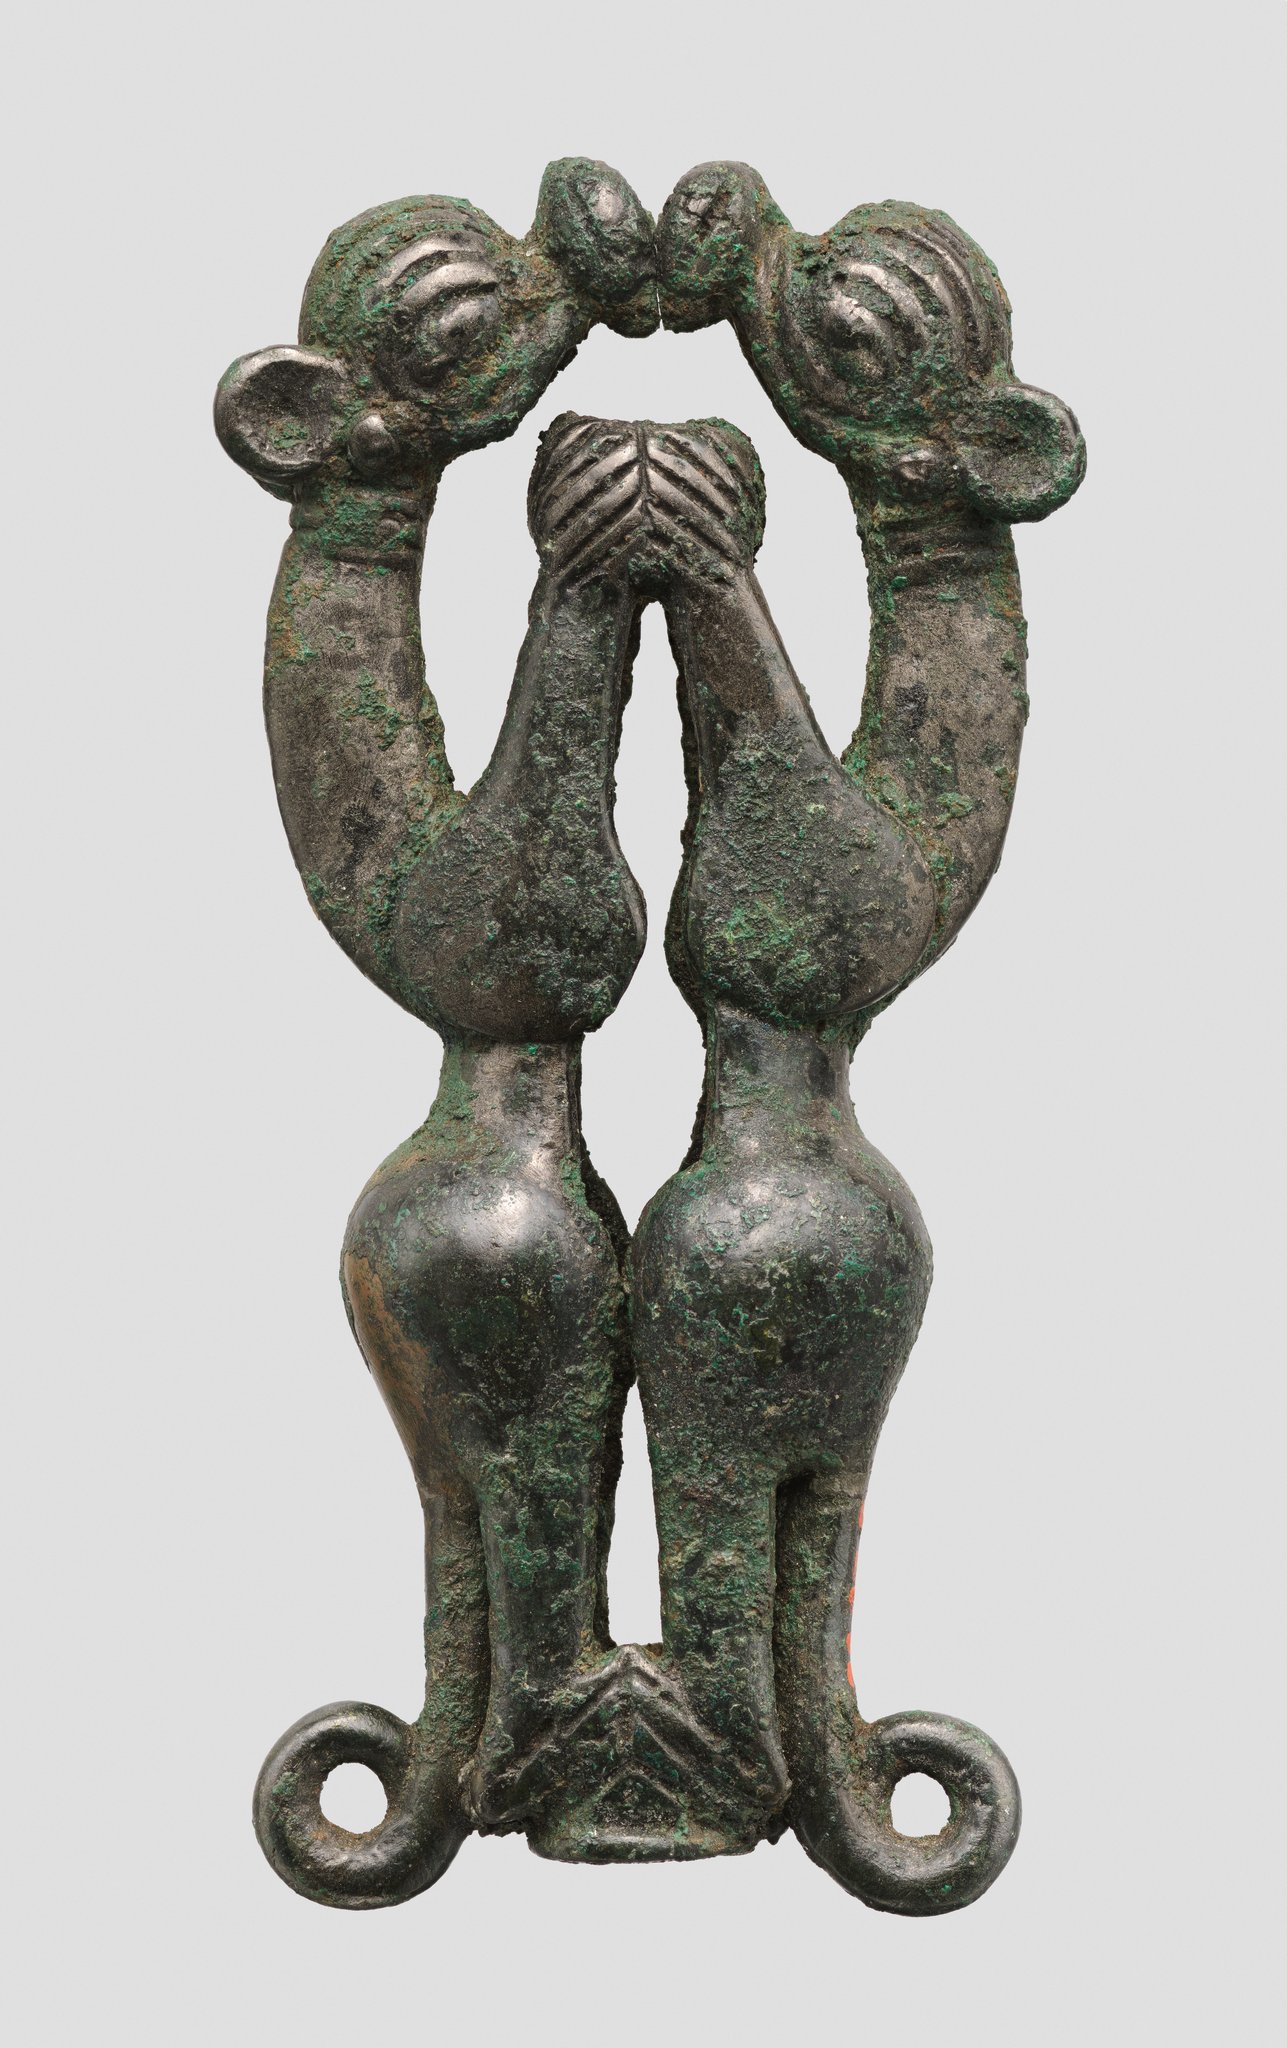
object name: standard top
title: Top for standard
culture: iranian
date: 800-601 BCE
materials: bronze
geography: iran, probably from luristan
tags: animals